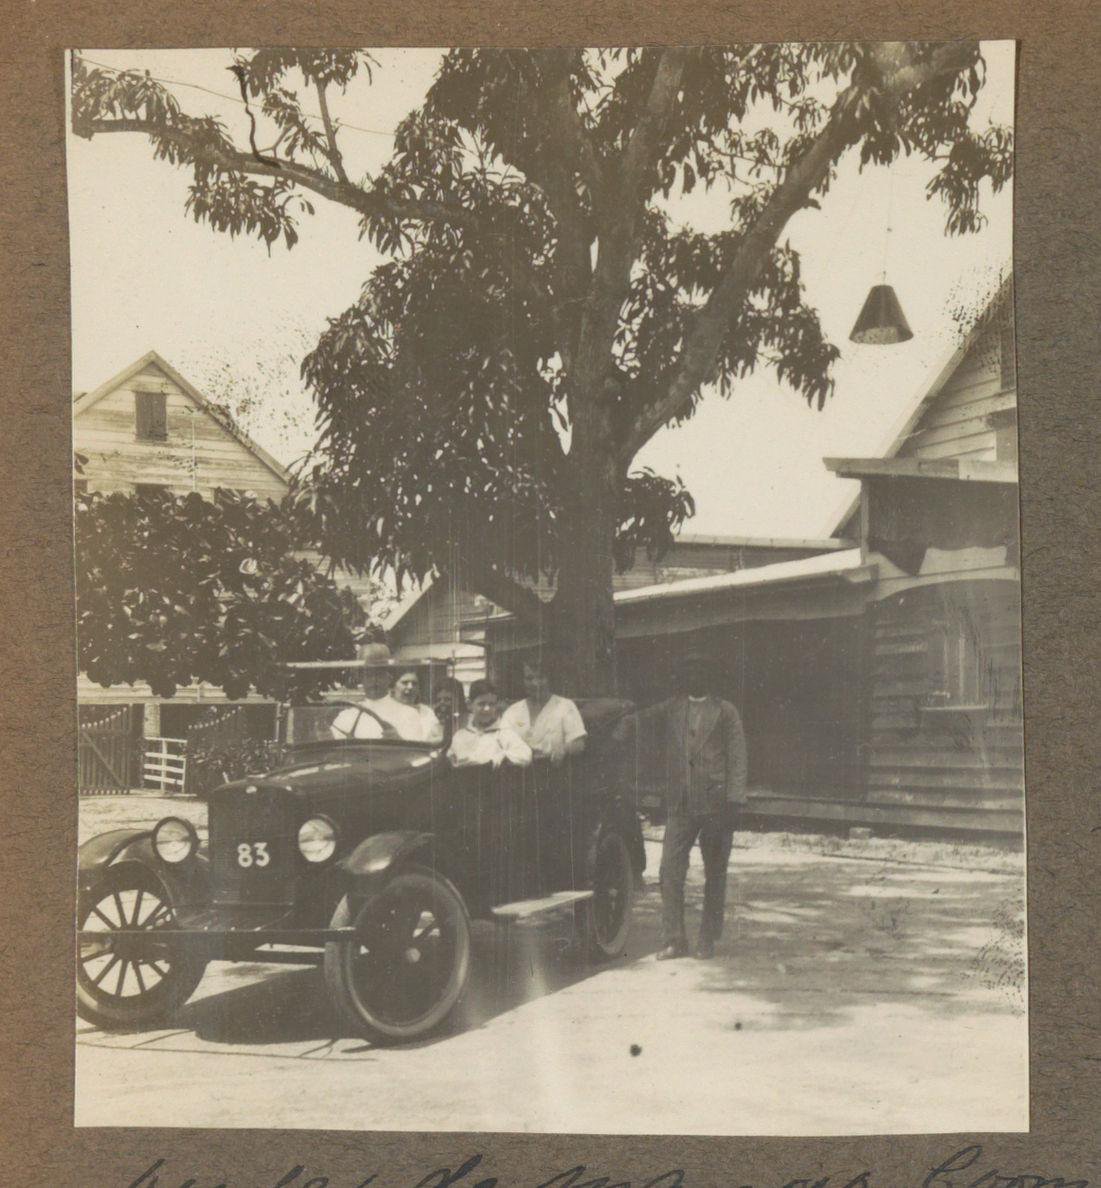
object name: photograph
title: Onder de mango-boom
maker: Anonymous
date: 1920-1930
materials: photographic support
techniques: gelatin silver print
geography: suriname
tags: trees, automobile, suriname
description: Onderdeel van fotoalbum van een onbekende Nederlandse familie met opnames van Suriname, Europa en Nederlands-Indië.